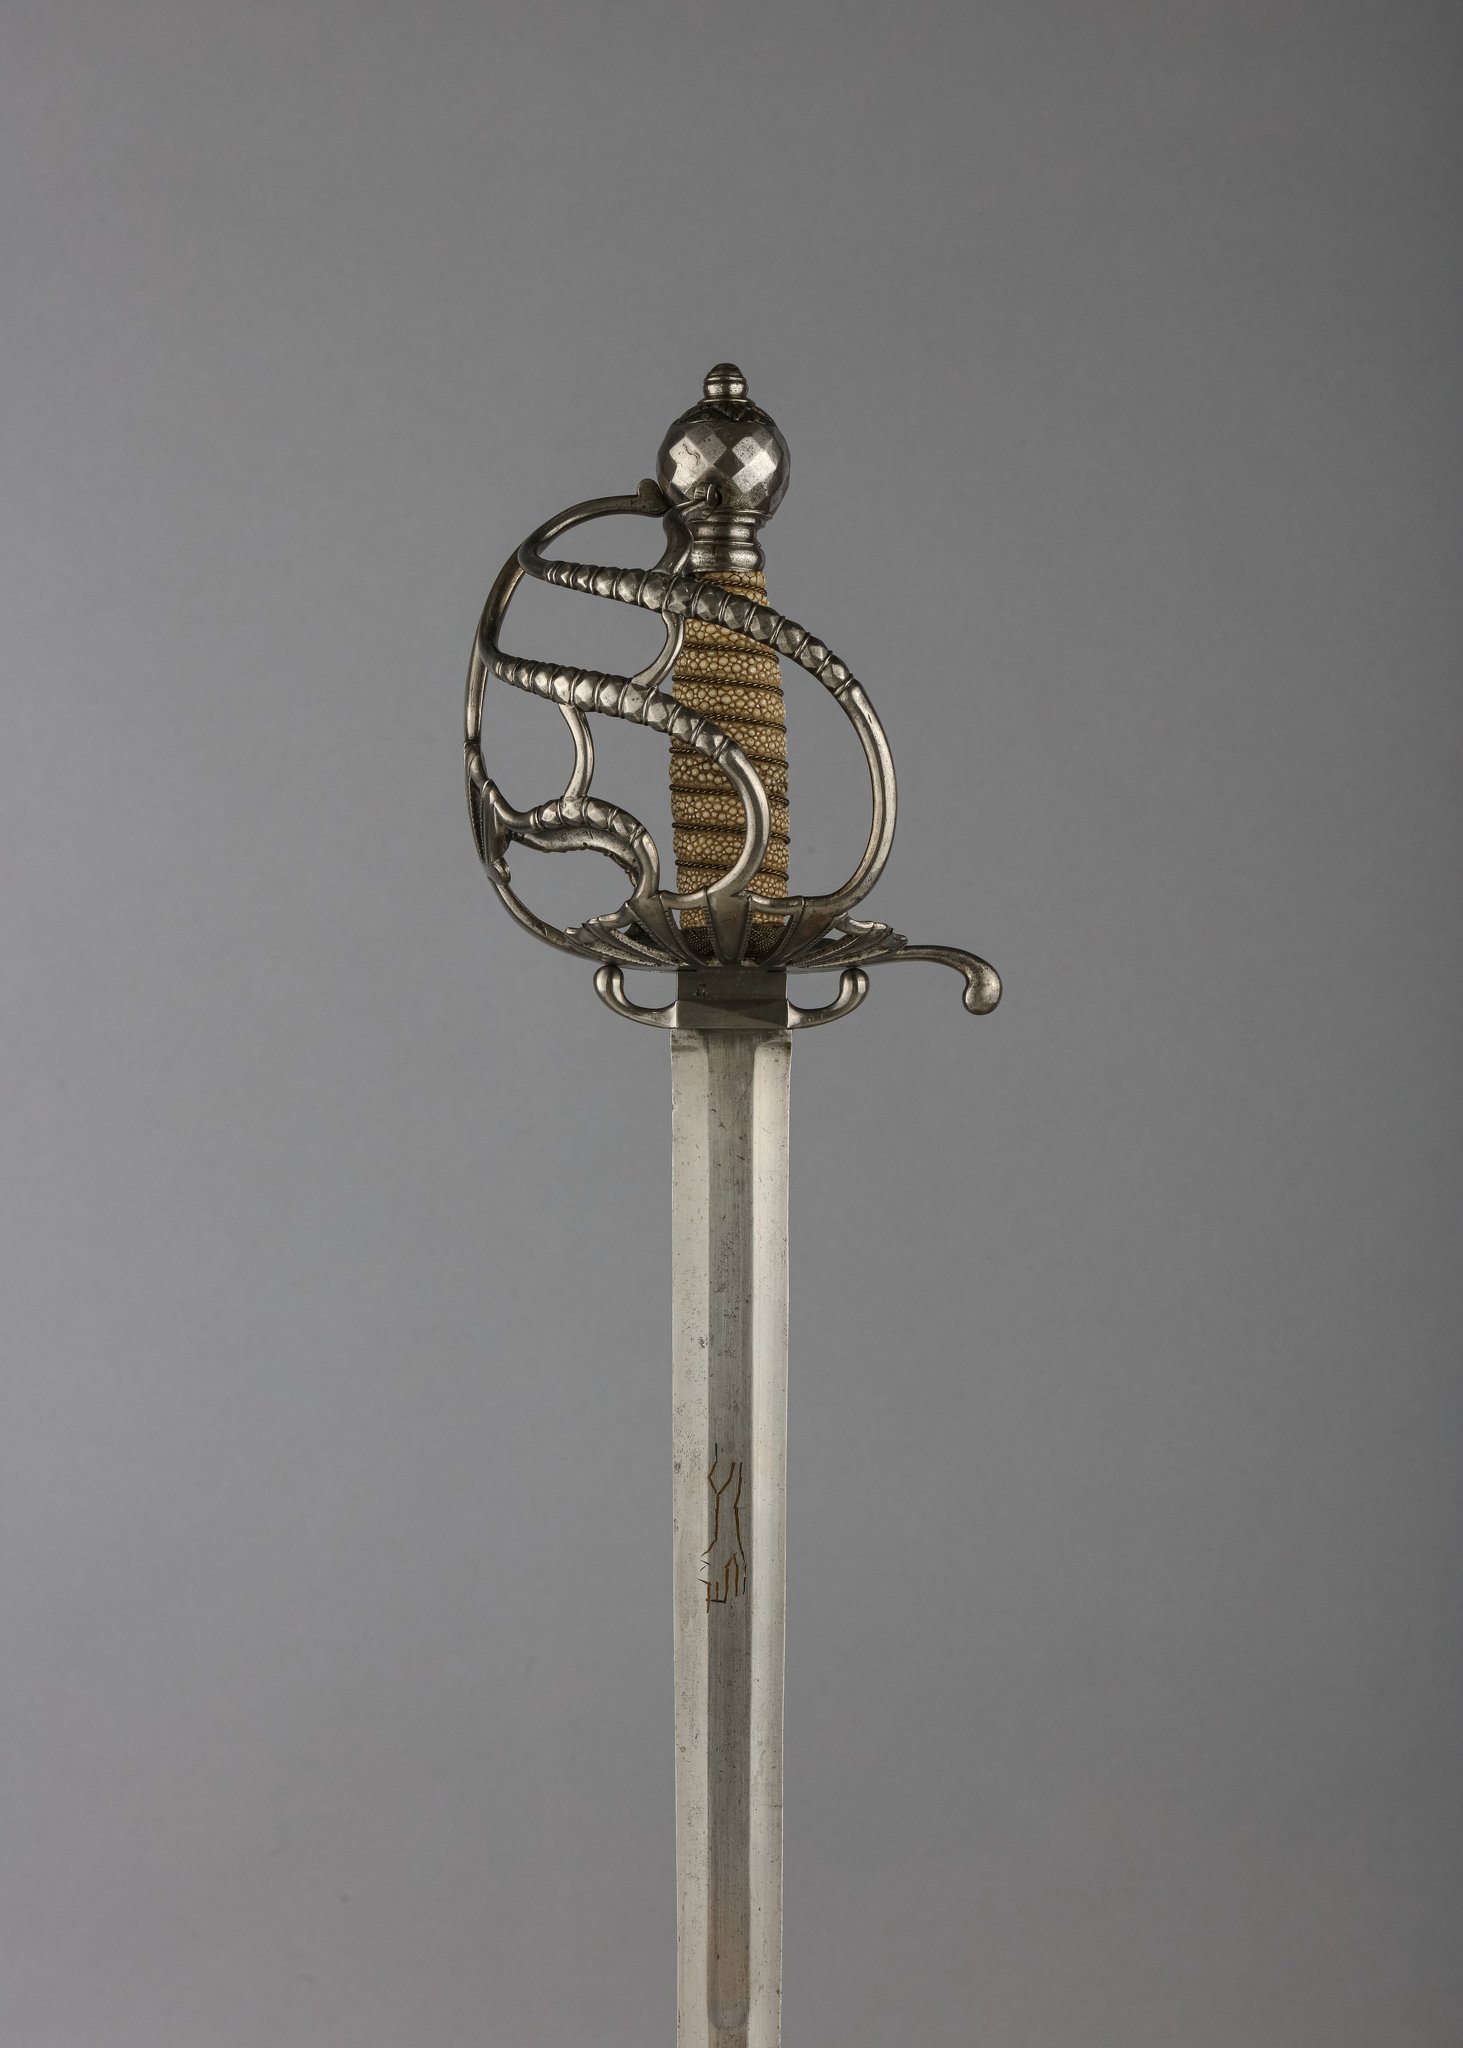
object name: broadsword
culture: italian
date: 1667-1733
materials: steel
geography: italy